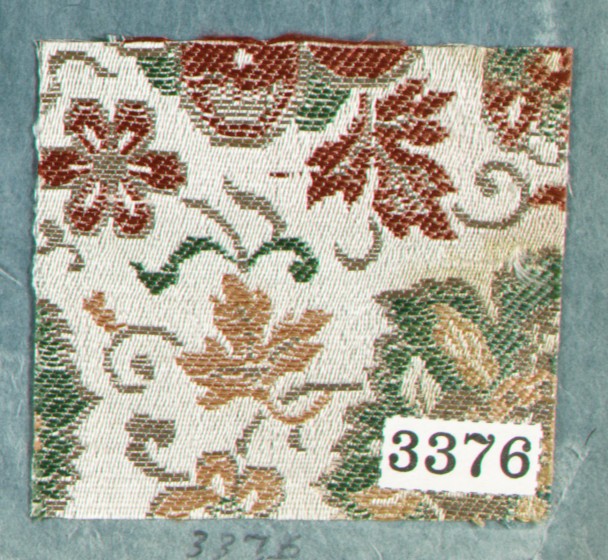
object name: textile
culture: japanese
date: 1801-1900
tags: flowers